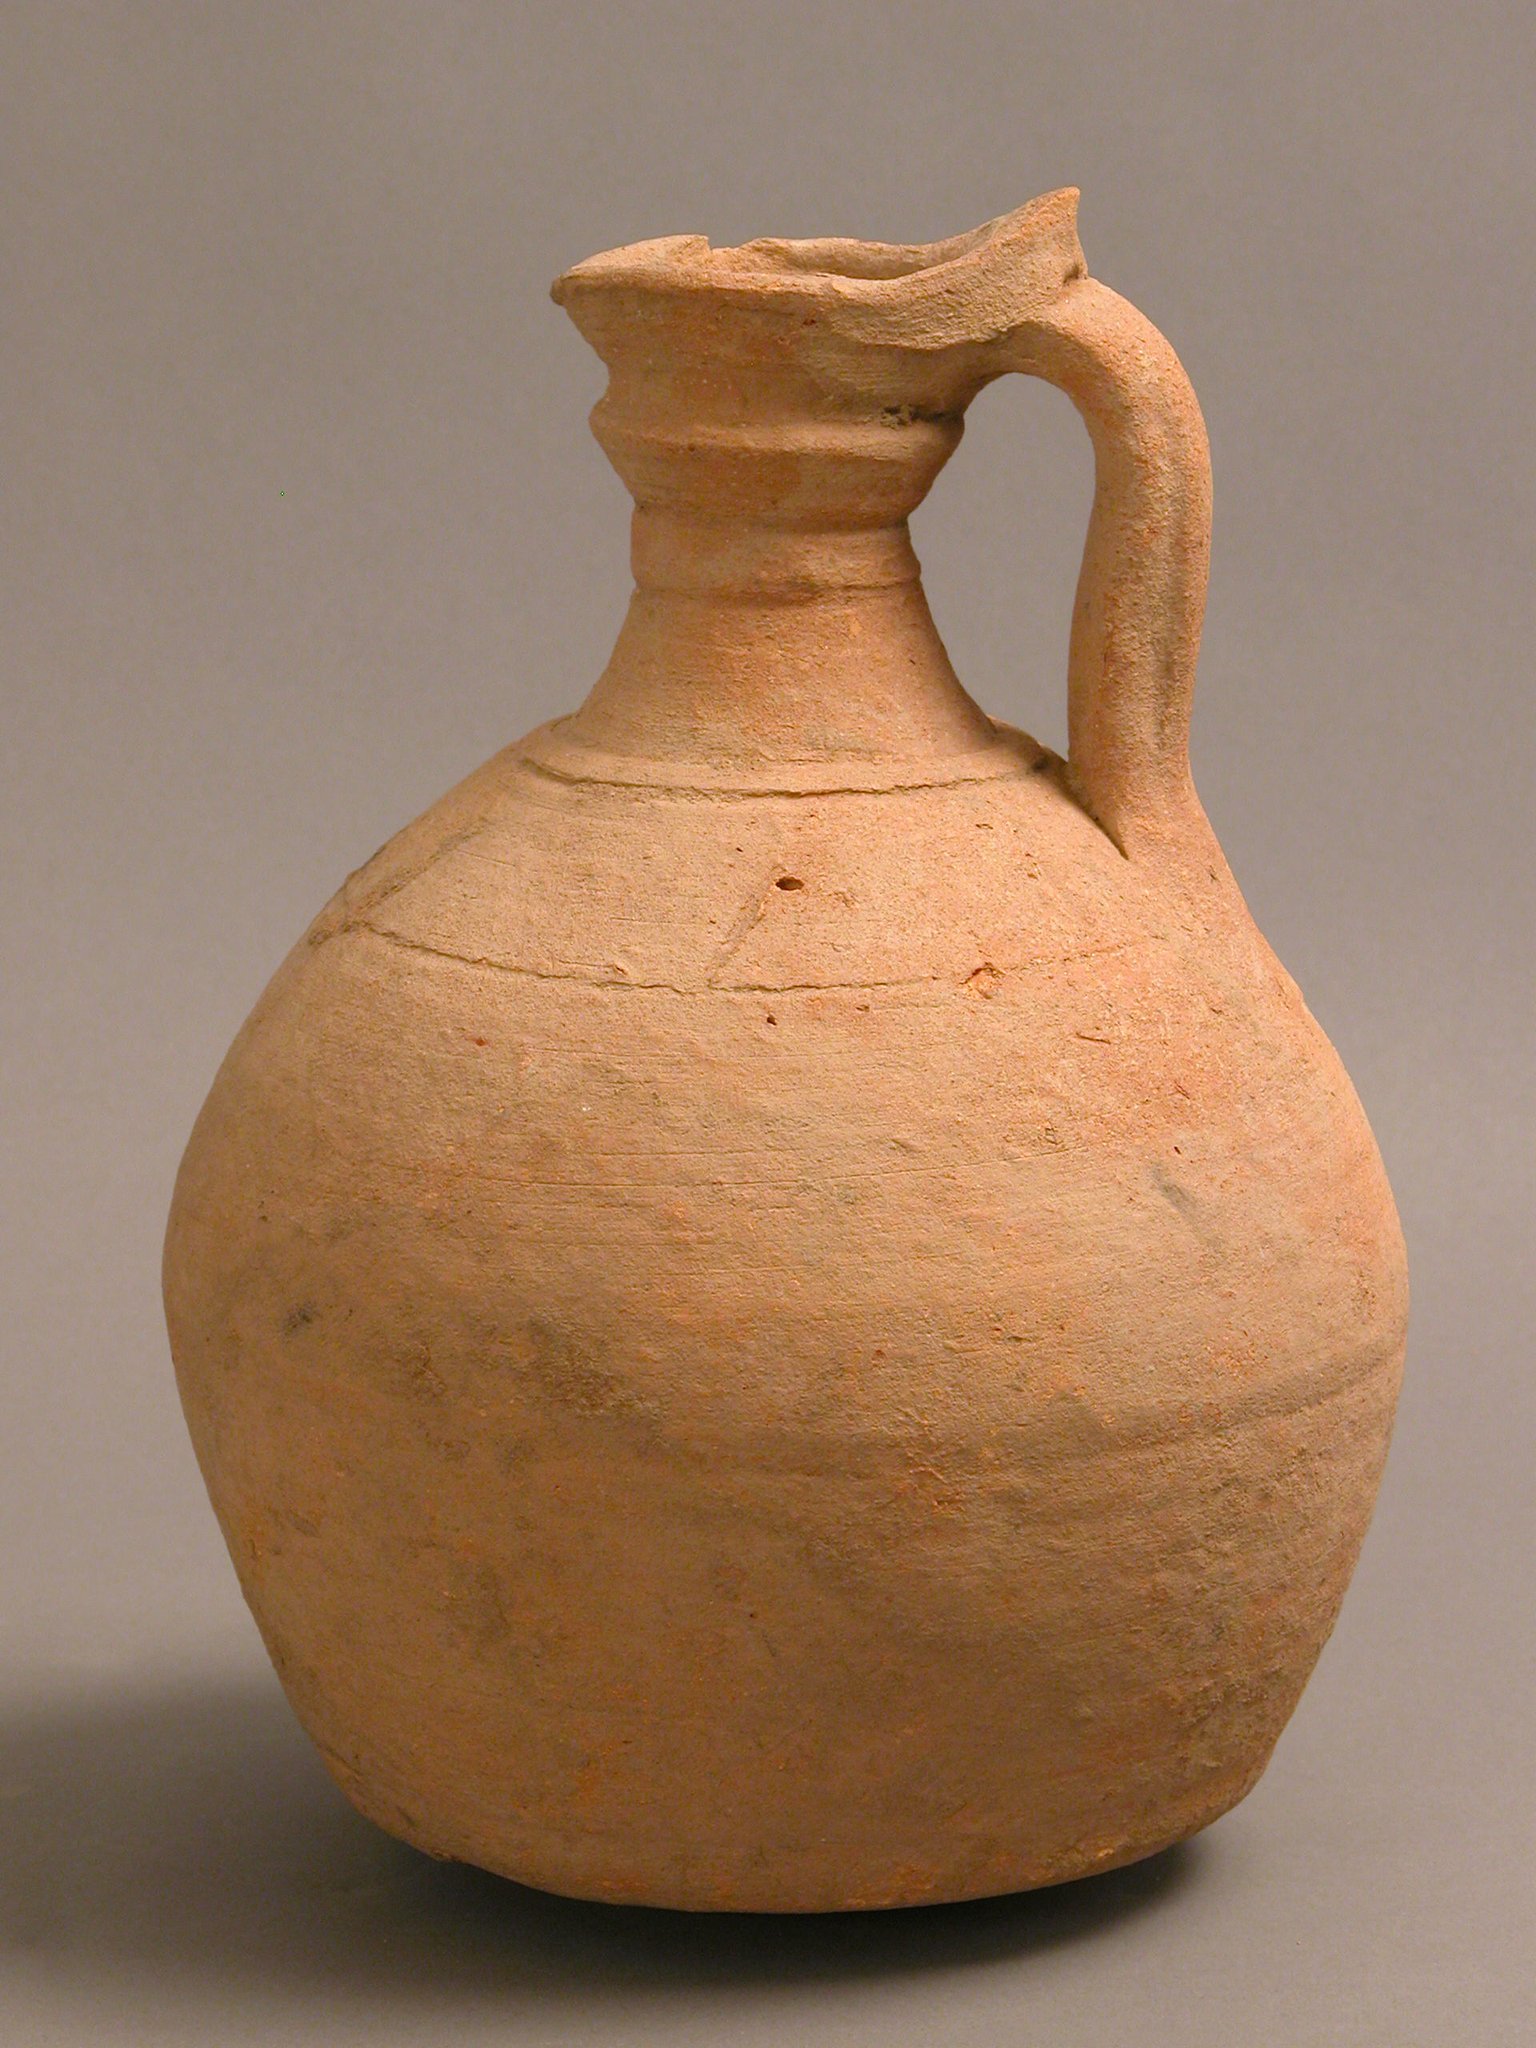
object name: jug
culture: coptic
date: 301-700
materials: earthenware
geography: egypt